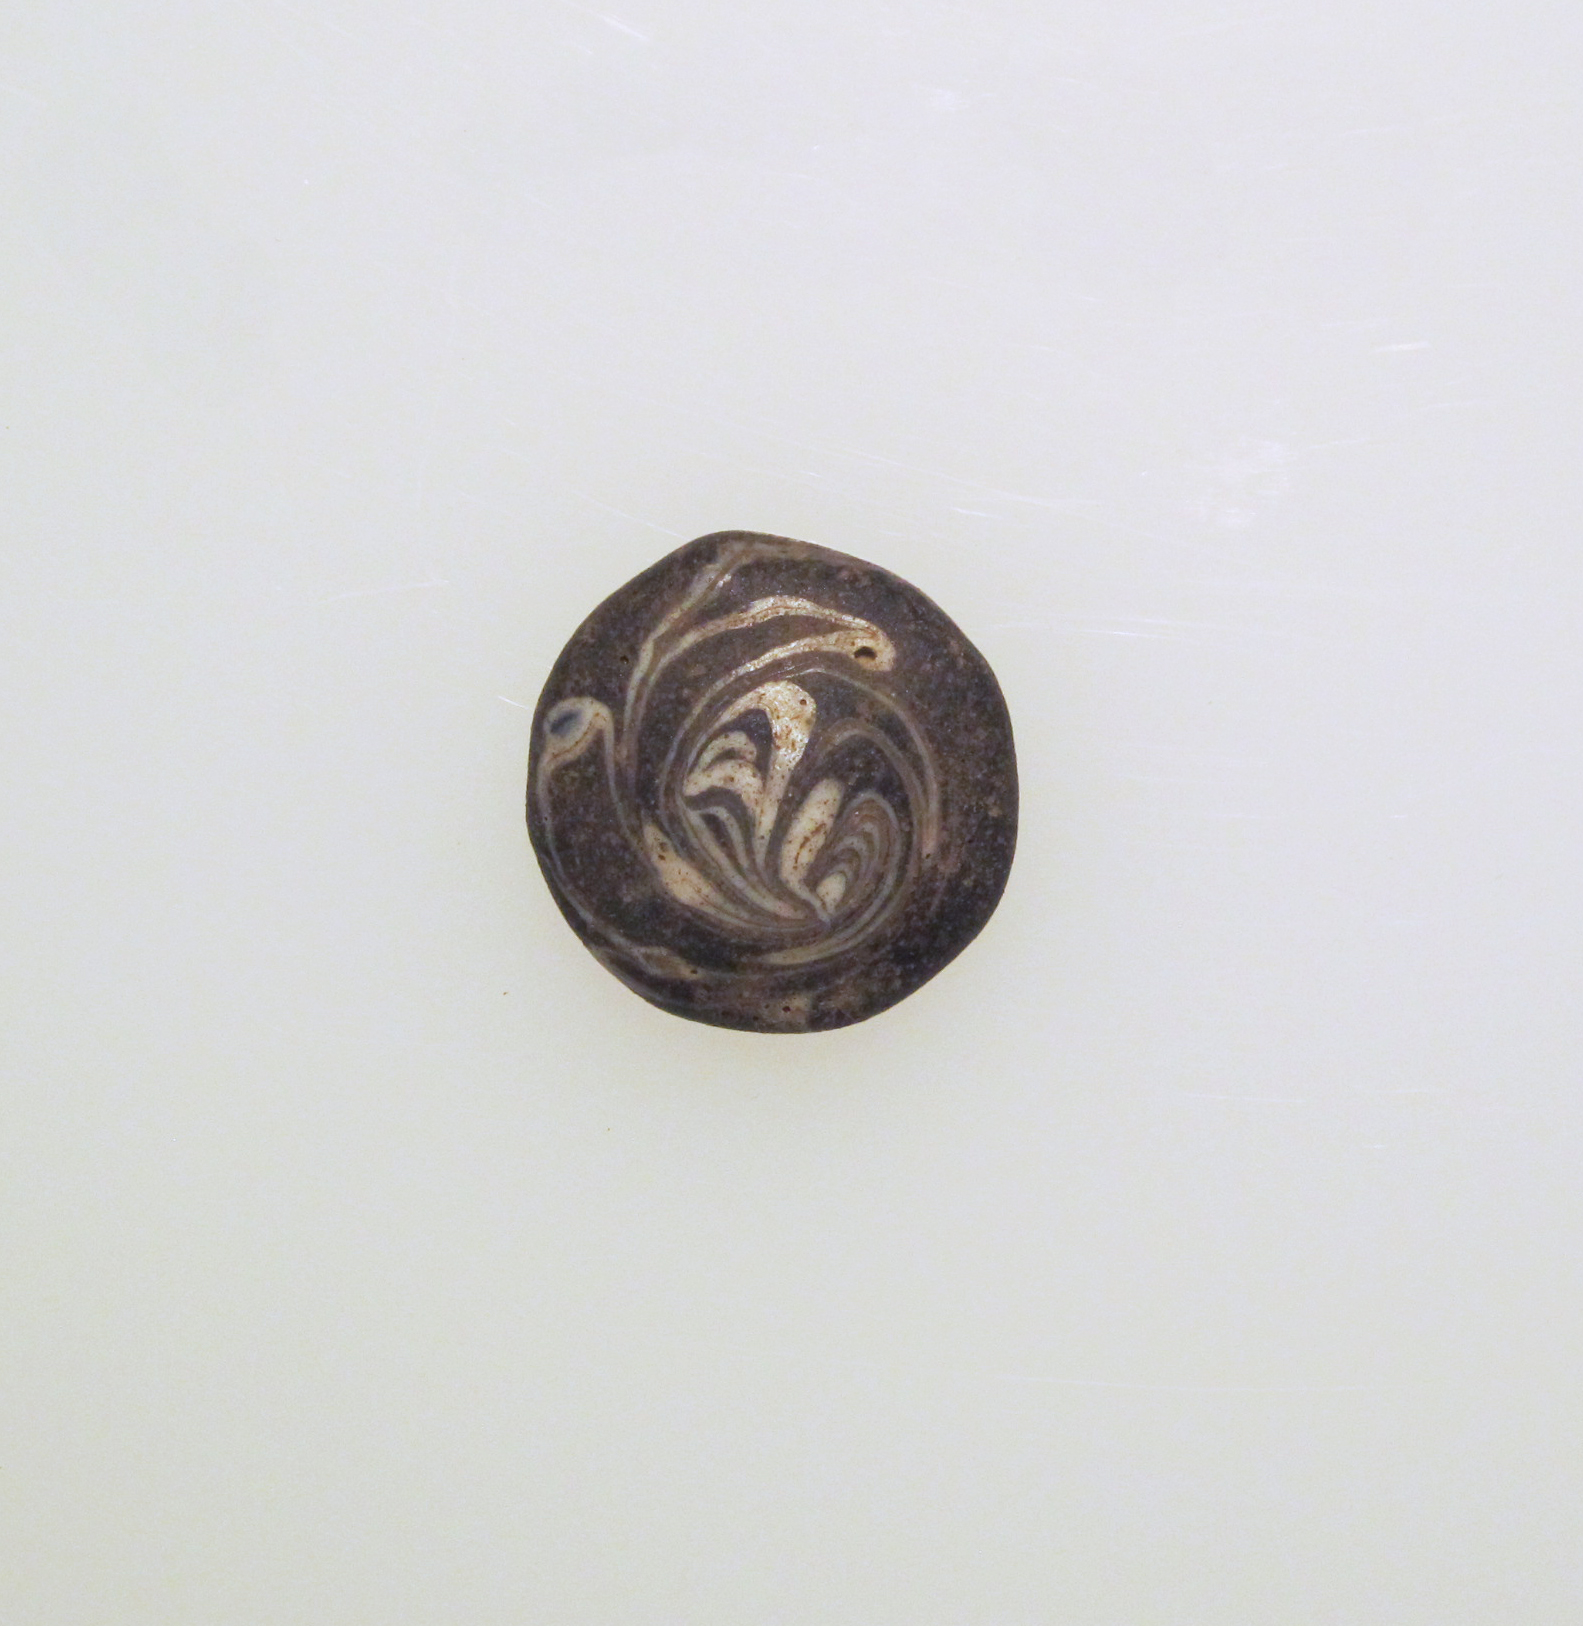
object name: pinhead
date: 7000 BCE-330 CE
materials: glass